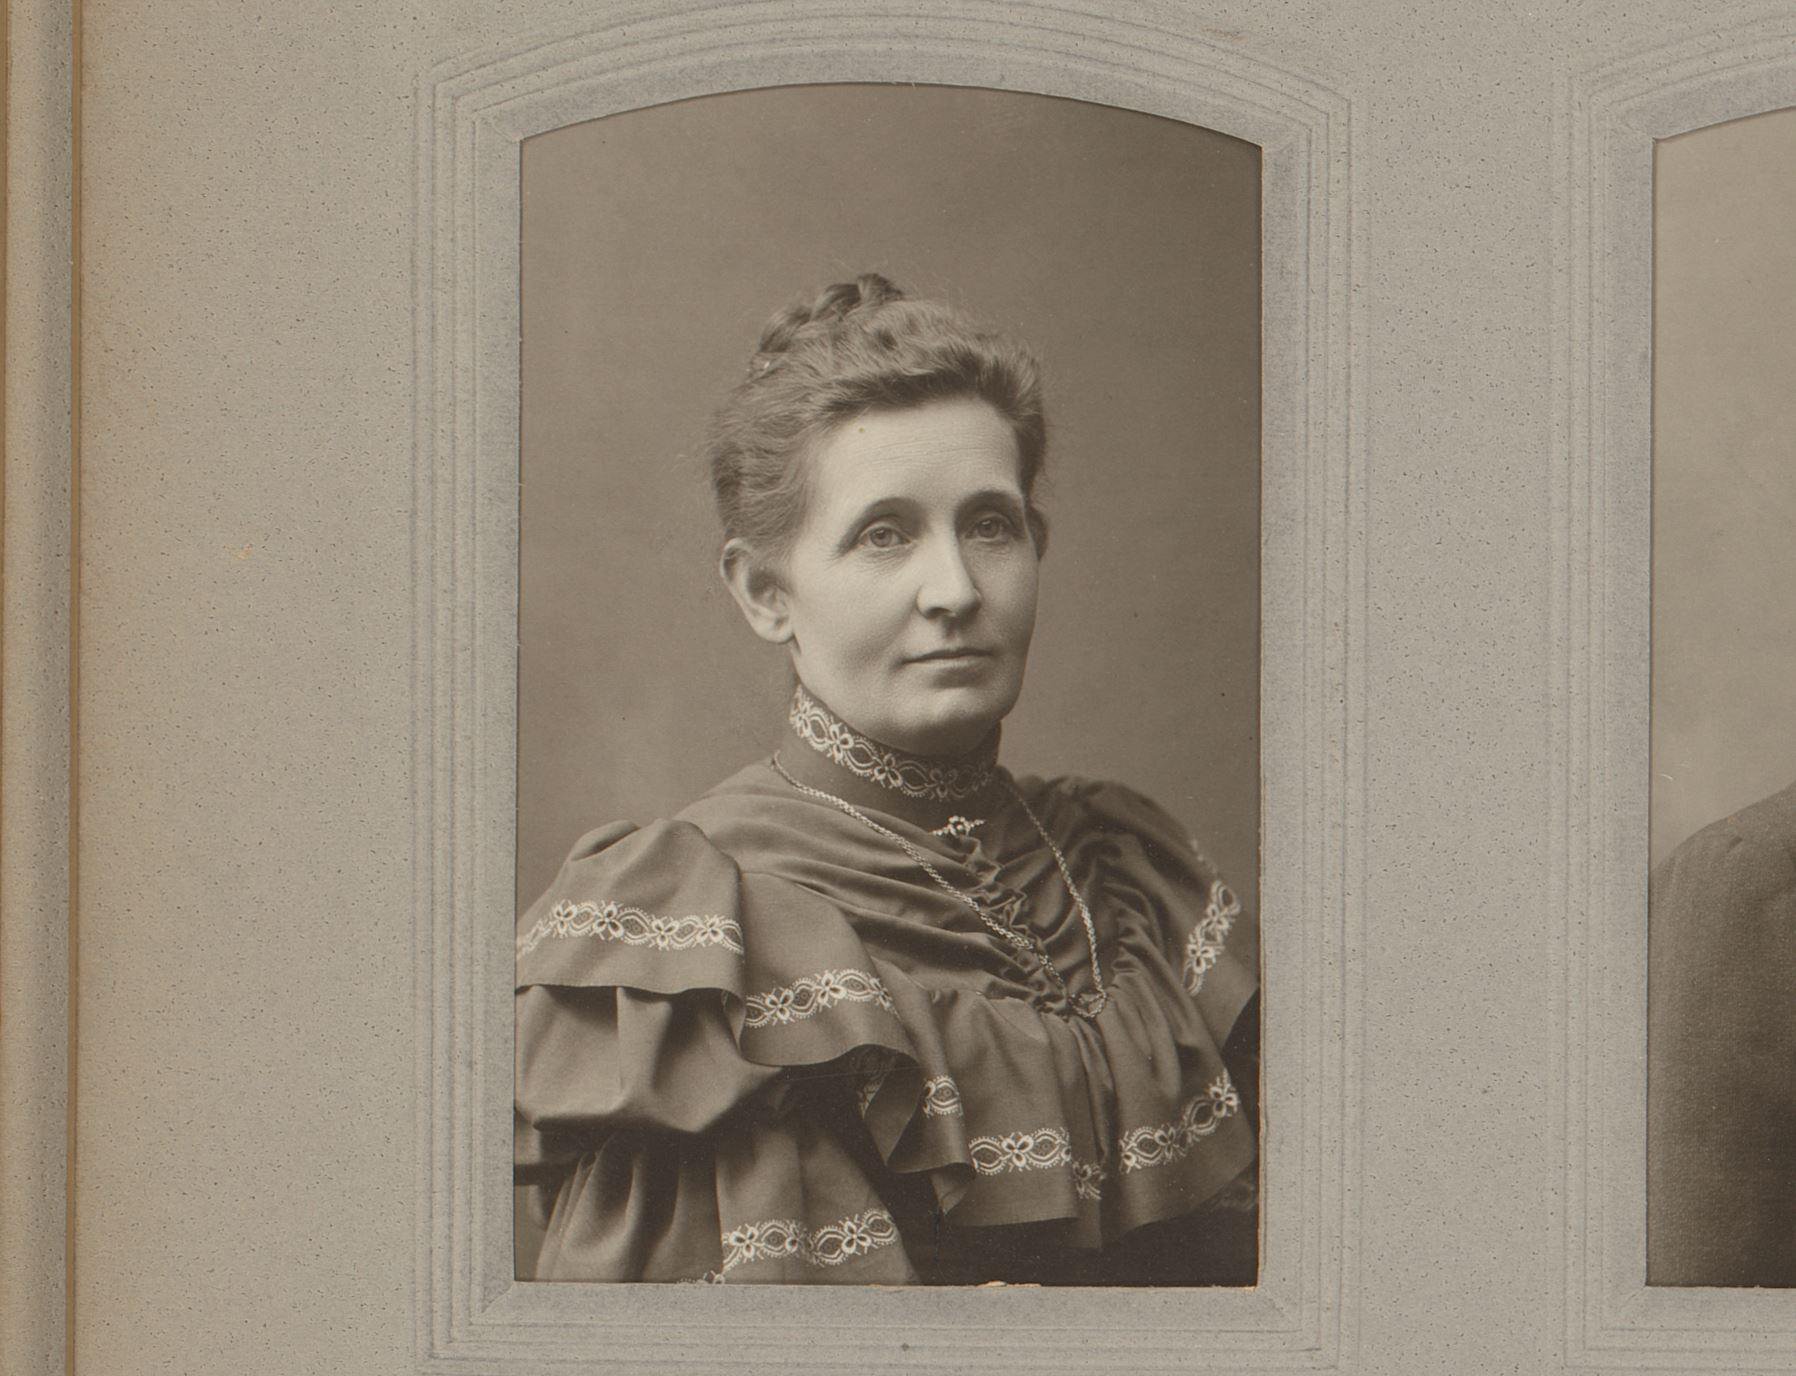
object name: carte de visite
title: Portret van een vrouw in hooggesloten jurk met halsketting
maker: gustaf lesser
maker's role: fotograaf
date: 1895-1920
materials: cardboard, photographic support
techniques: matte daylight collodion silver print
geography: eskilstuna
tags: historical persons - bb - woman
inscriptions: inscription: ‘Telefon 460./ Gustaf Lesser/ Smedjegatan 2.C./ Eskilstuna./ Plåten förvaras.’